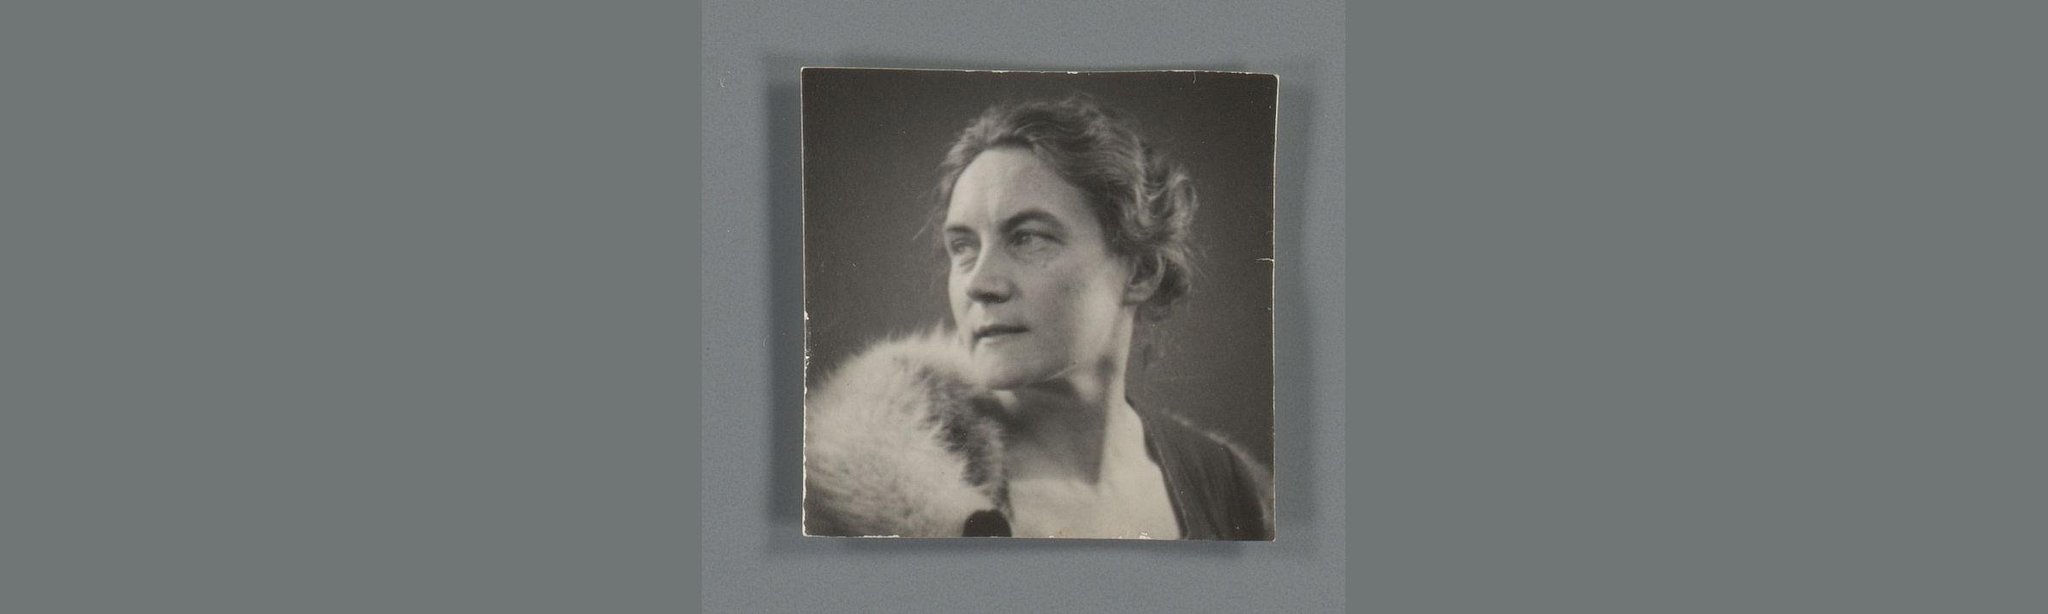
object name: snapshot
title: Portret van Johanna (Hans) de Jong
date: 1903-1940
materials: paper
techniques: gelatin silver print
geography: the hague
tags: leiden, johanna petronella lambertina stokhuyzen-de jong (hans), historical persons - bb - woman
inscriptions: number: ‘31’